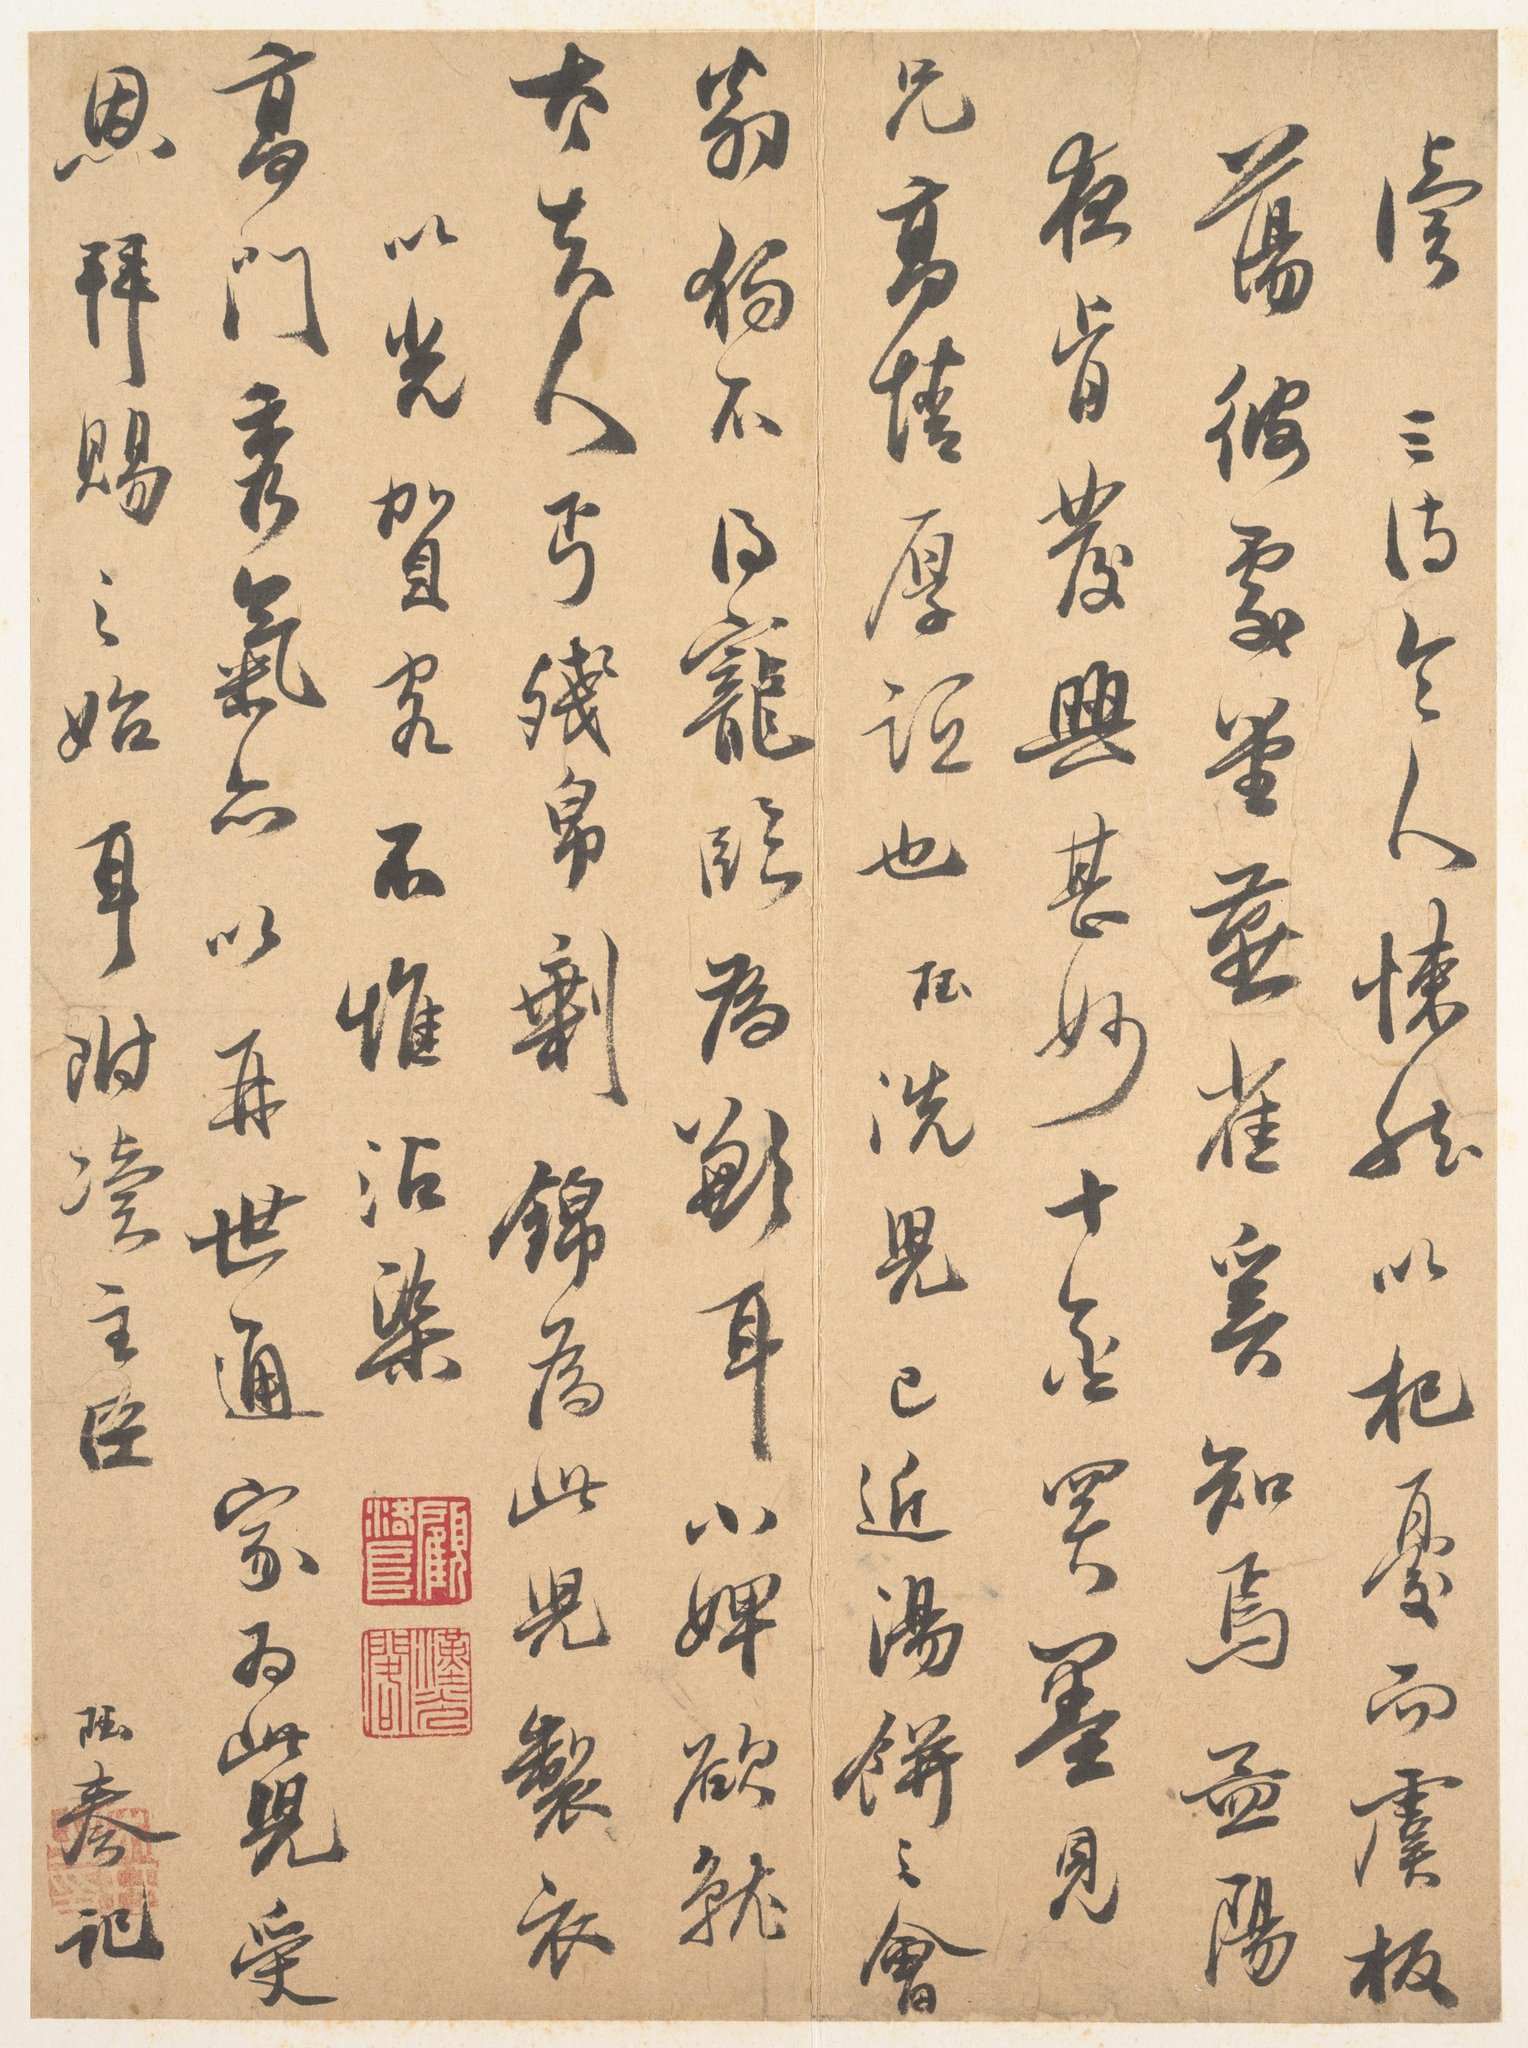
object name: album leaf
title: Letter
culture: chinese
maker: song jue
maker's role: artist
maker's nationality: chinese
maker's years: 1576-1632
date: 1601-1633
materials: ink, paper